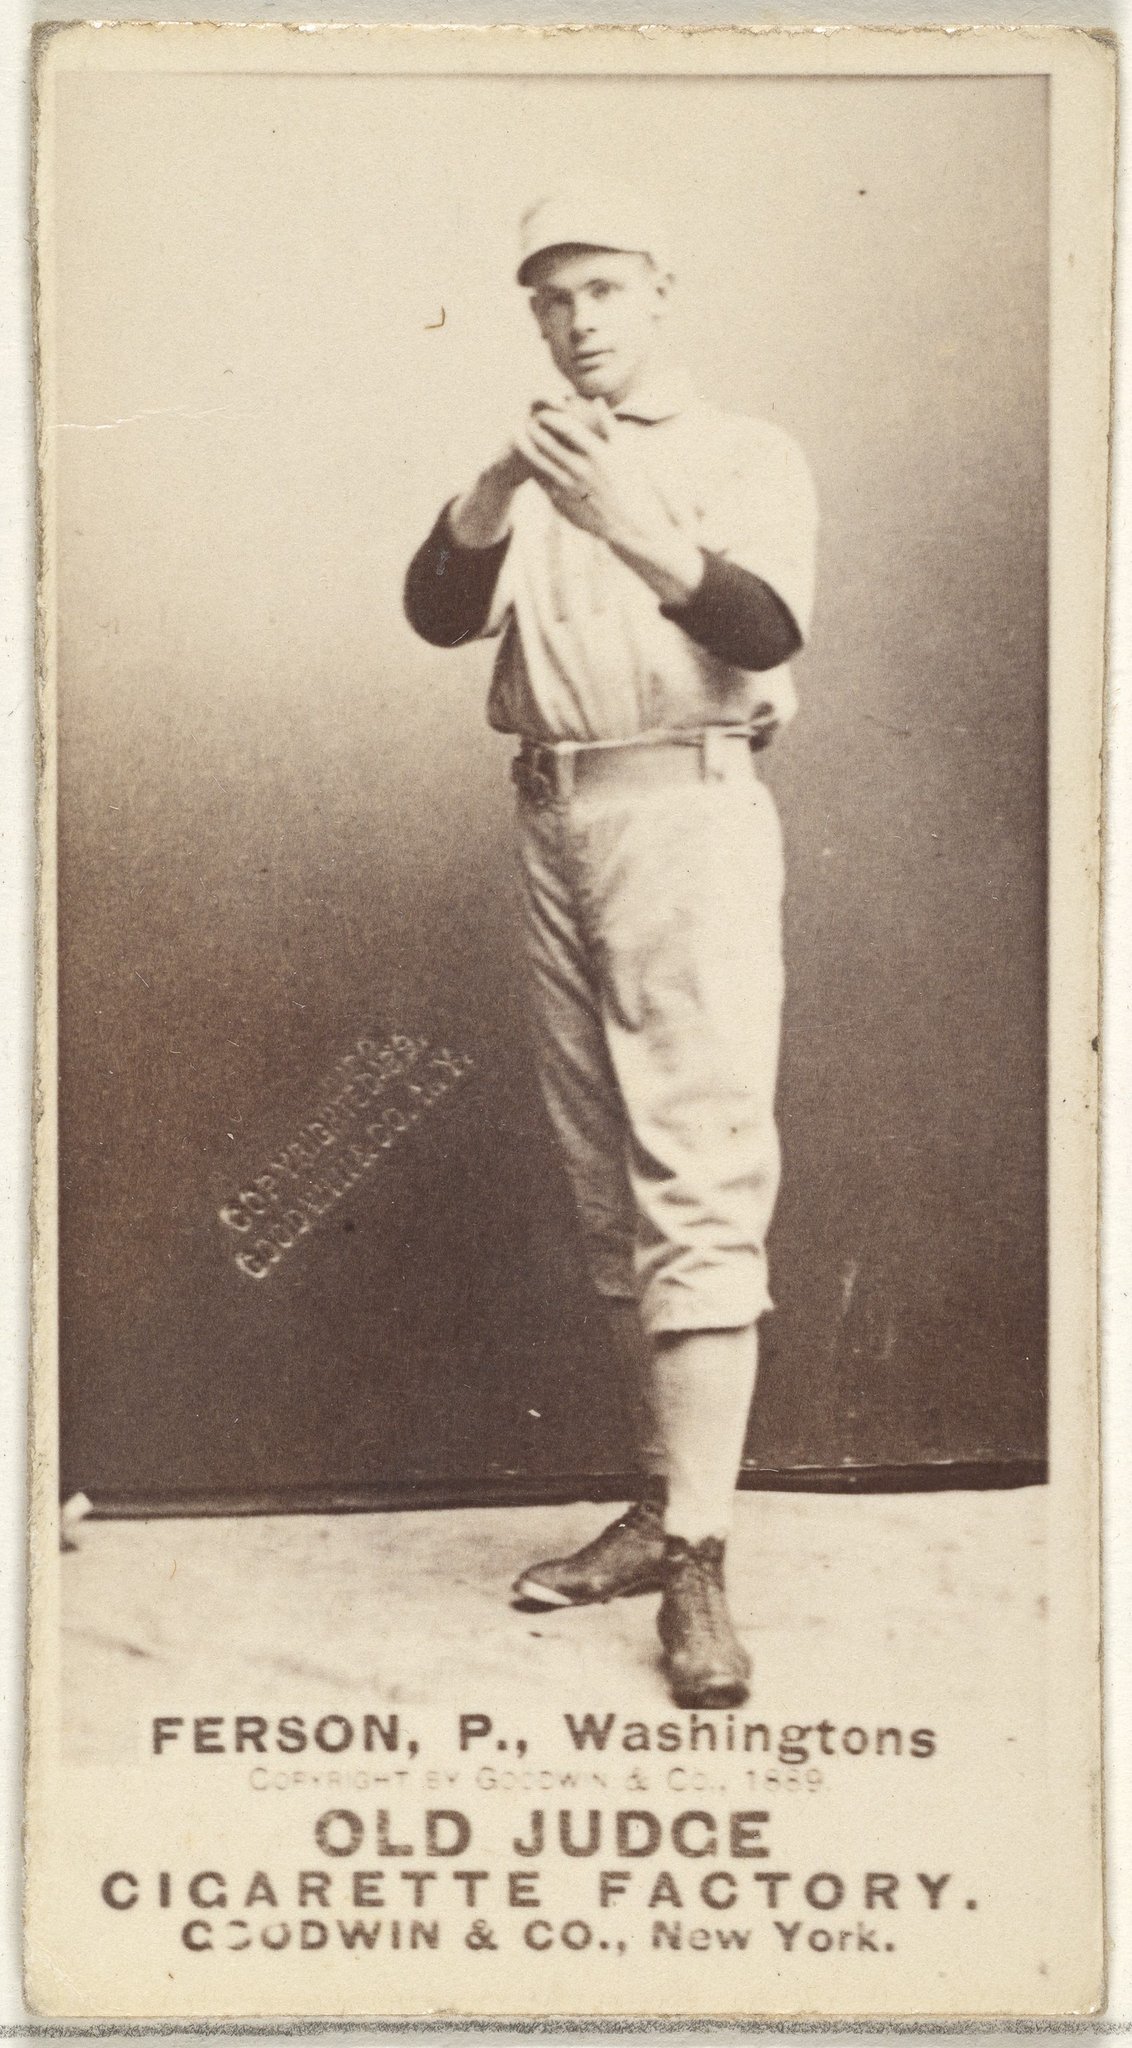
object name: baseball card, photograph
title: Alexander "Colonel" Ferson, Pitcher, Washington Nationals, from the Old Judge series (N172) for Old Judge Cigarettes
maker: goodwin & company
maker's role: publisher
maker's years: 1850-1950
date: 1889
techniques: albumen silver print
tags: men,portraits,baseball,athletes